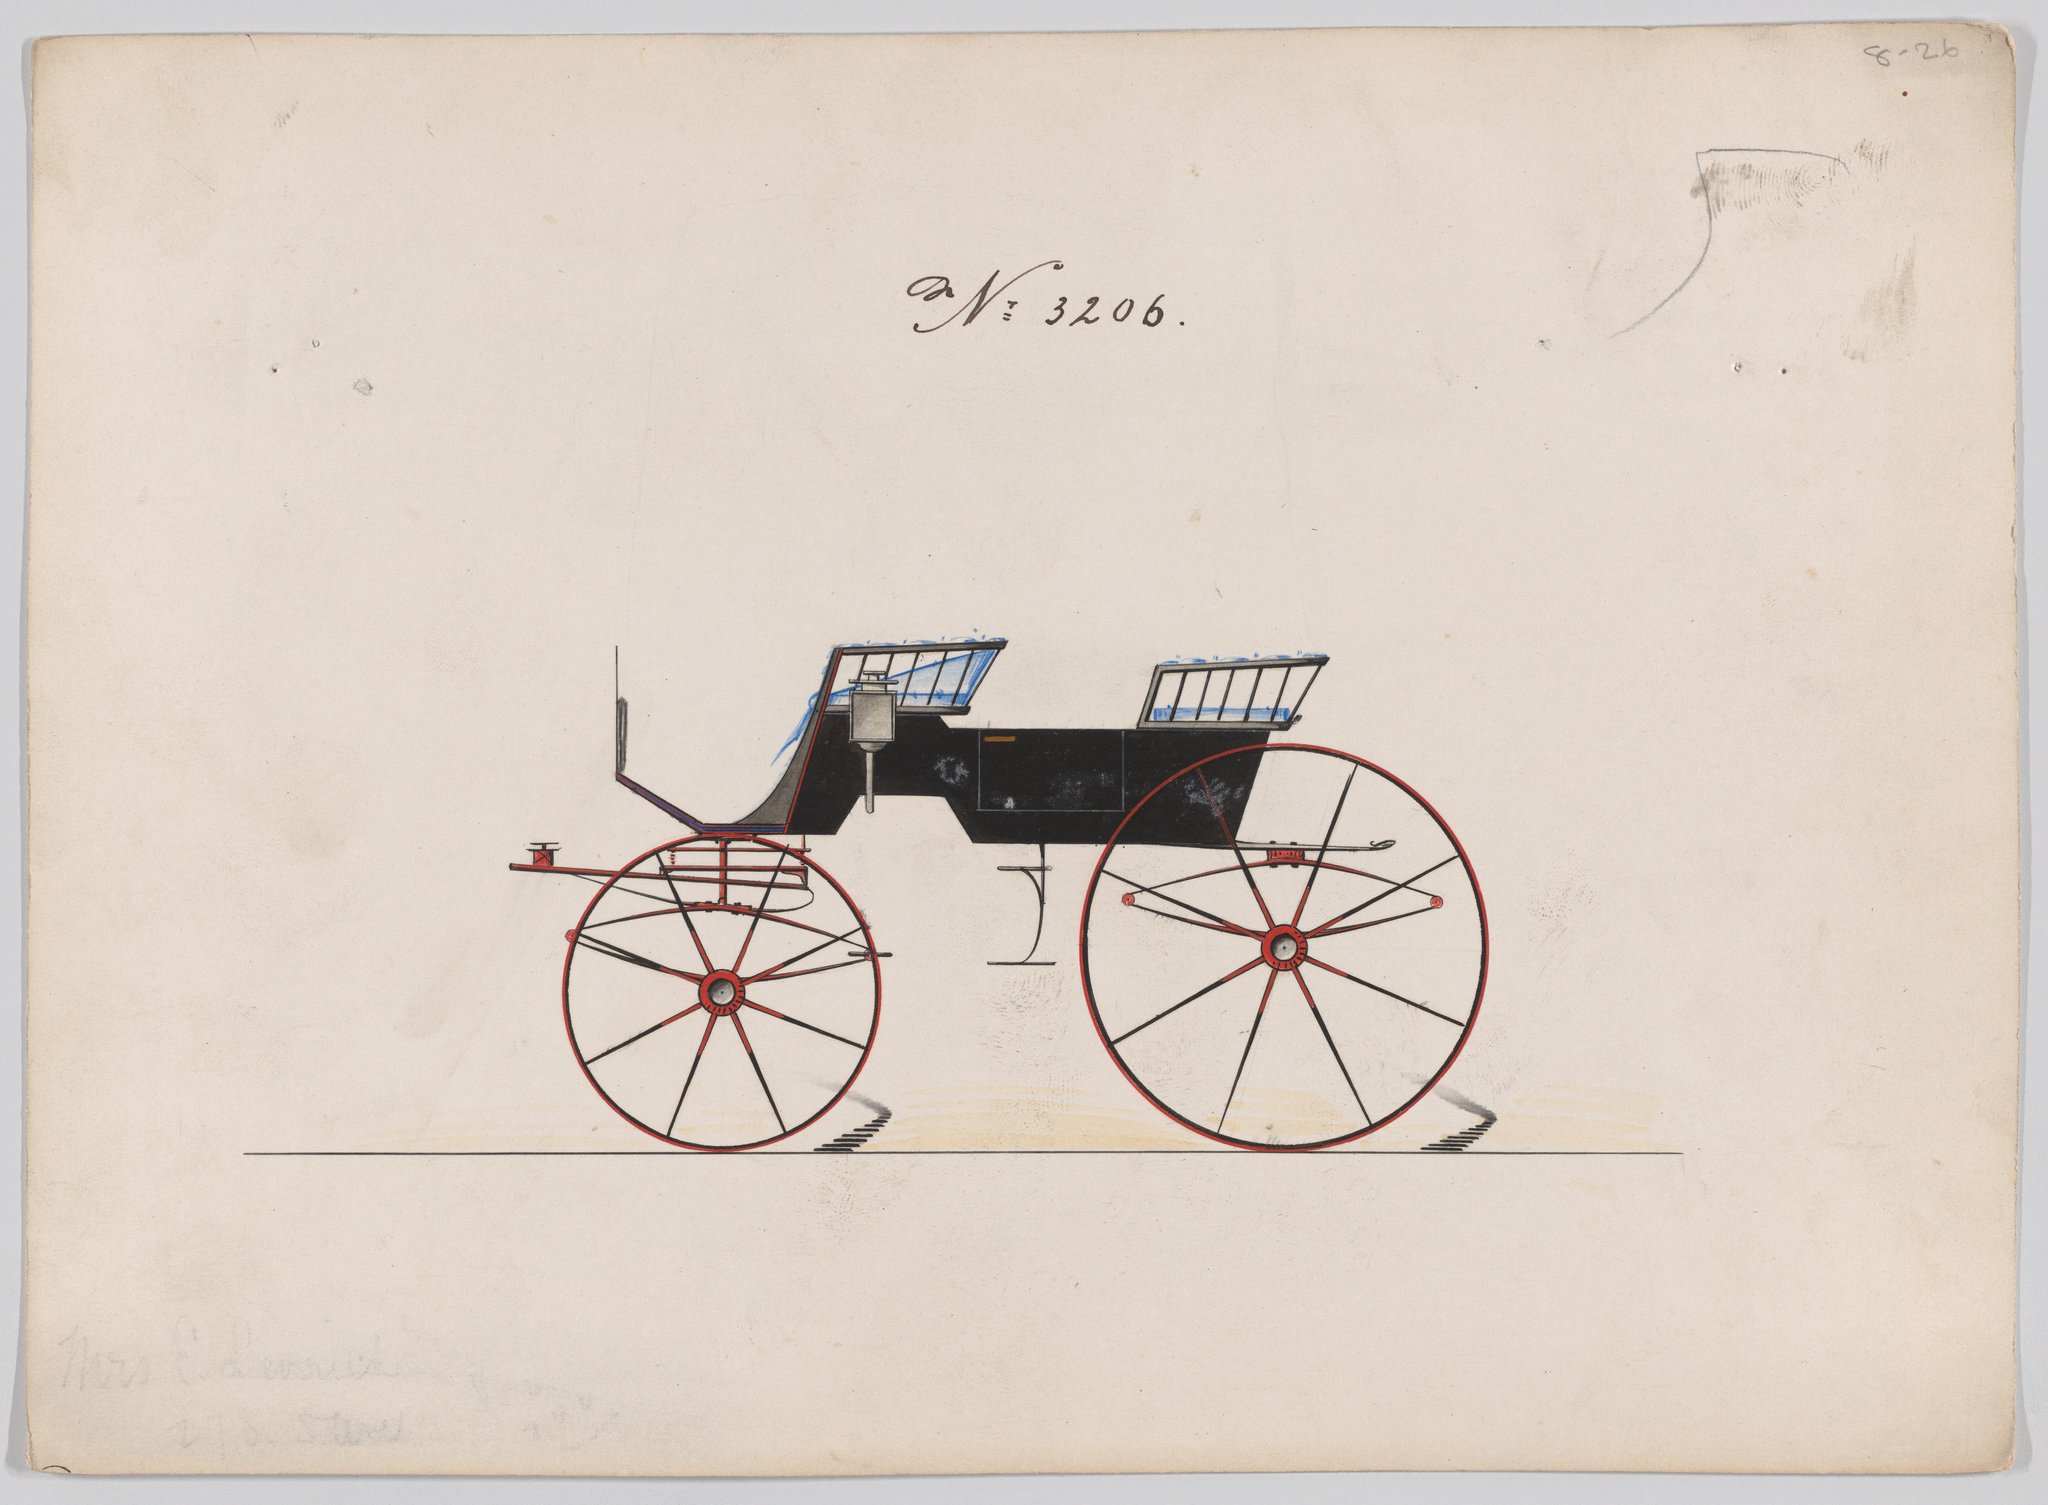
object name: drawing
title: Design for 4 seat Phaeton, no top, no. 3206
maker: brewster & co.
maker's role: manufacturer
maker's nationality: american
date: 1876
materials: gouache, gum arabic, ink, watercolor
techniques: pen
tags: carriages